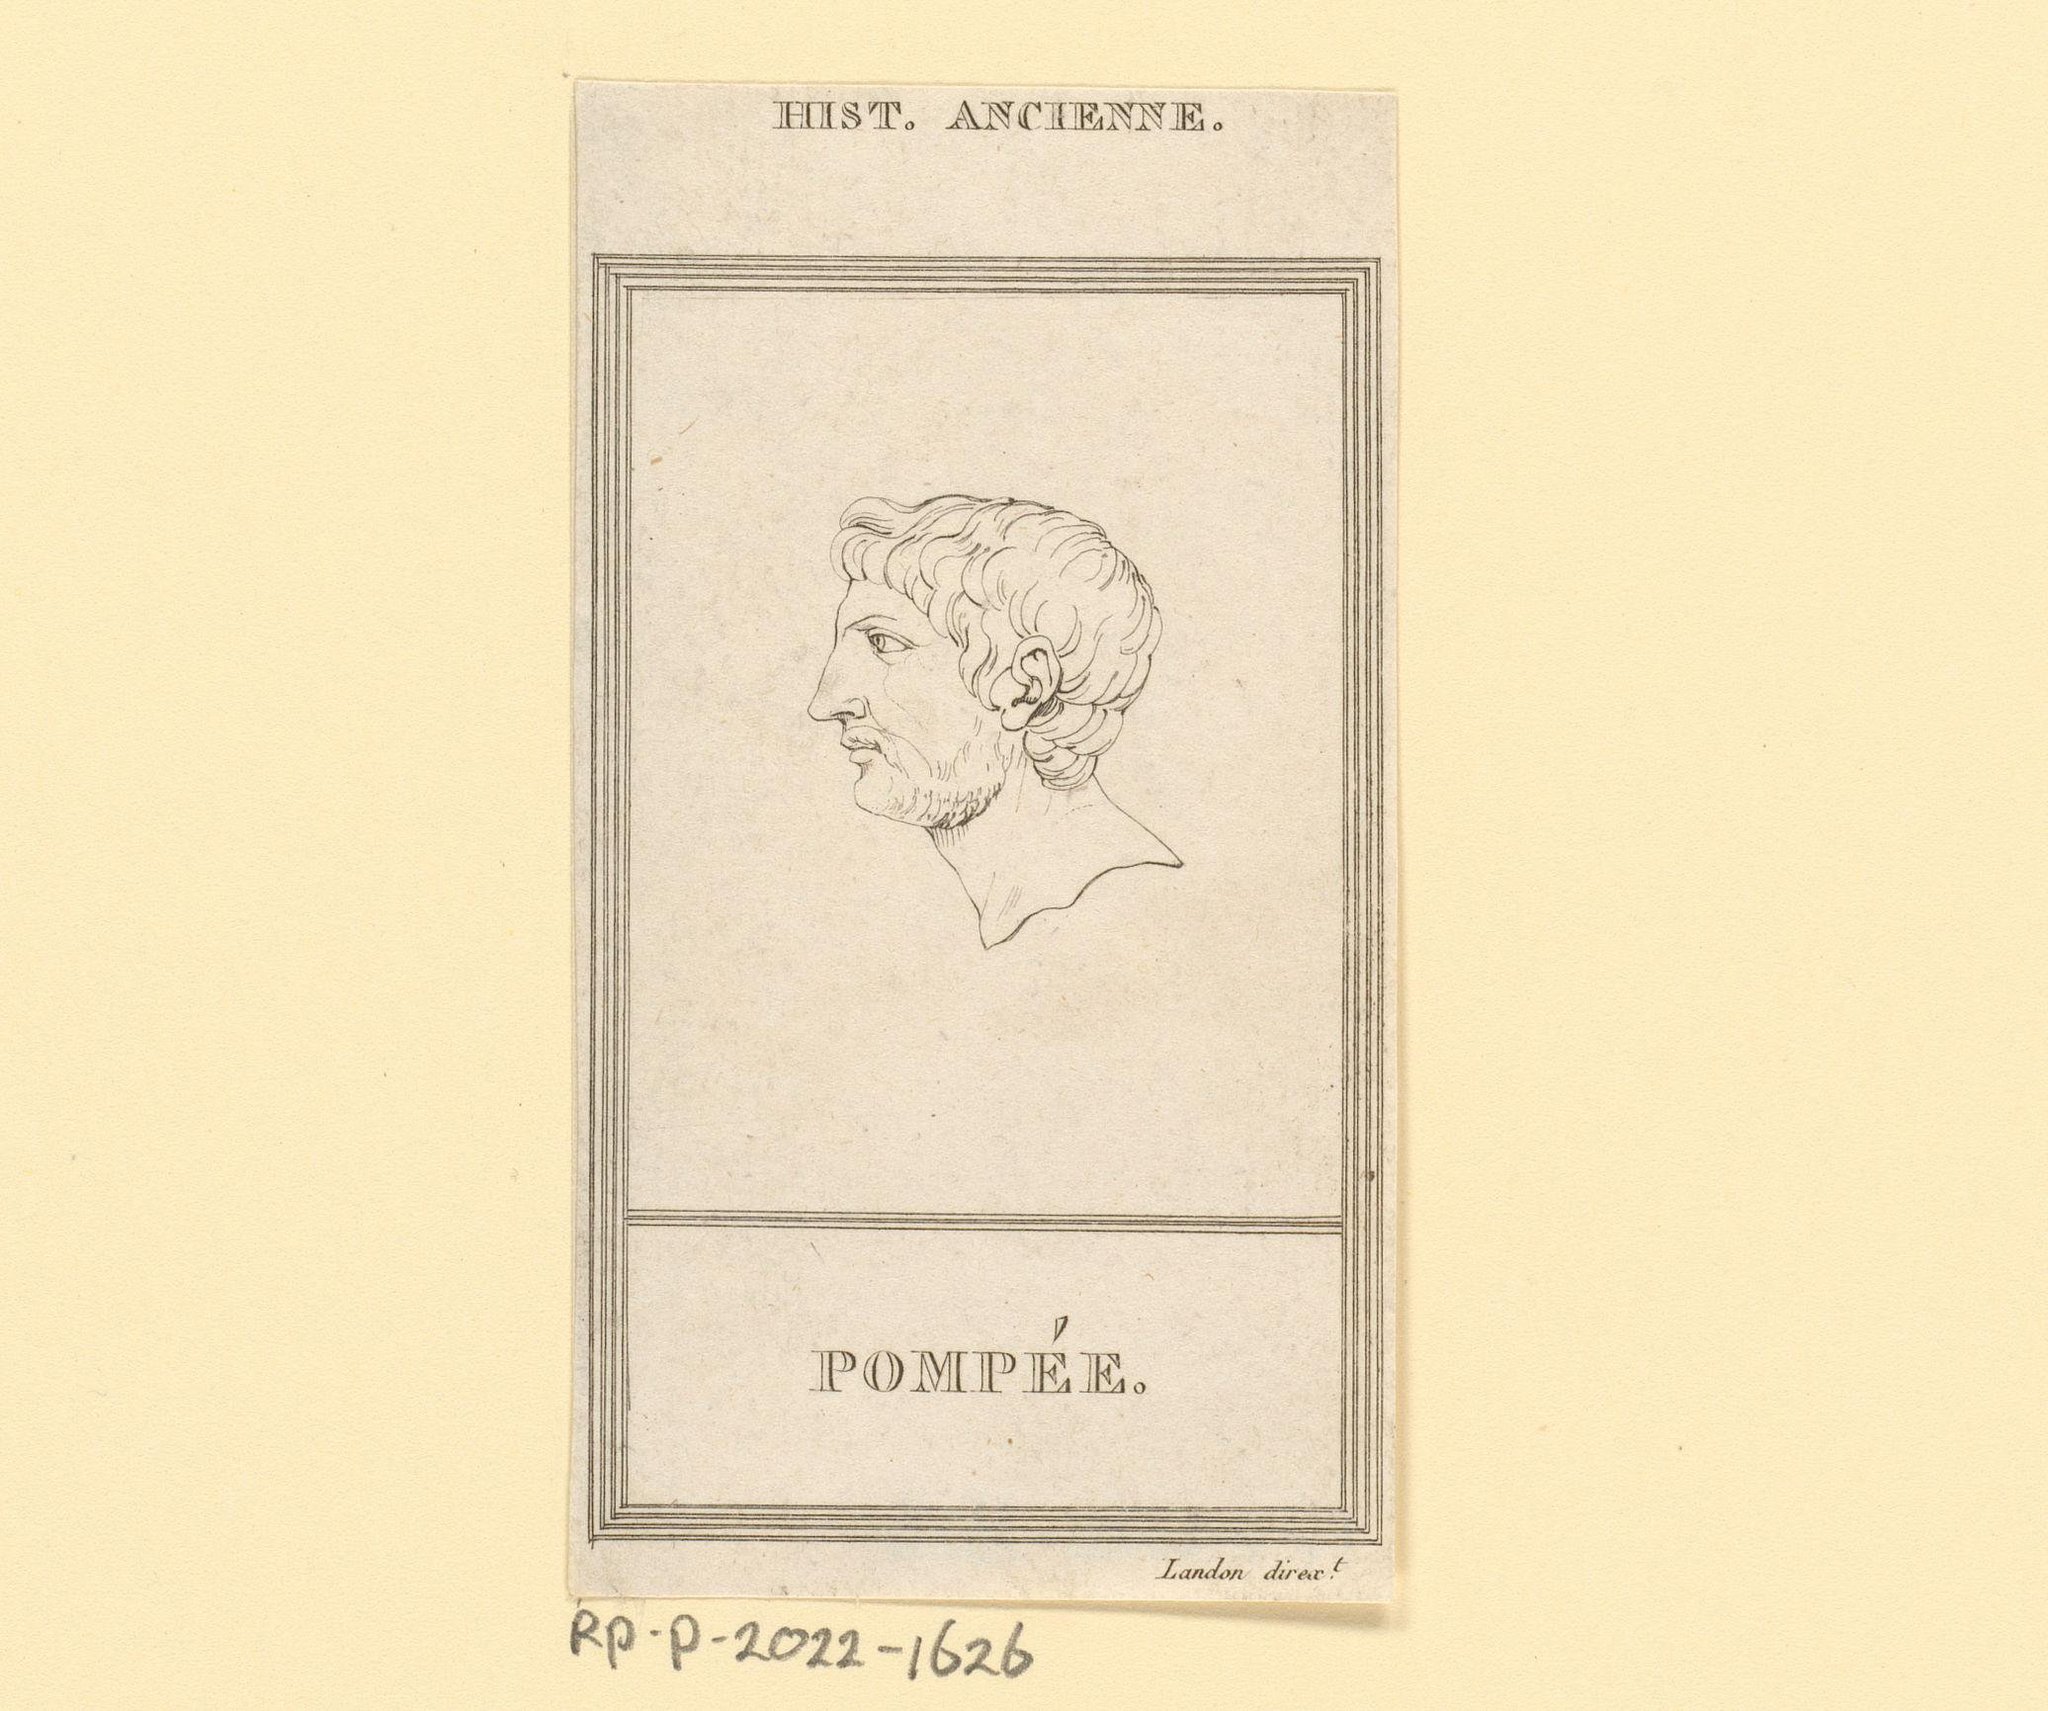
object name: print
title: Portret van Pompeius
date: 1810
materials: paper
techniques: etching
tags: rome, politician, commander-in-chief, general, marshal, historical persons, politician, e.g. party leader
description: Prent waarschijnlijk uit: Choix de biographie ancienne et moderne, à l'usage de la jeunesse, ou Notices sur les hommes les plus célèbres. Parijs: Charles Paul Landon, 1810, dl. 2.